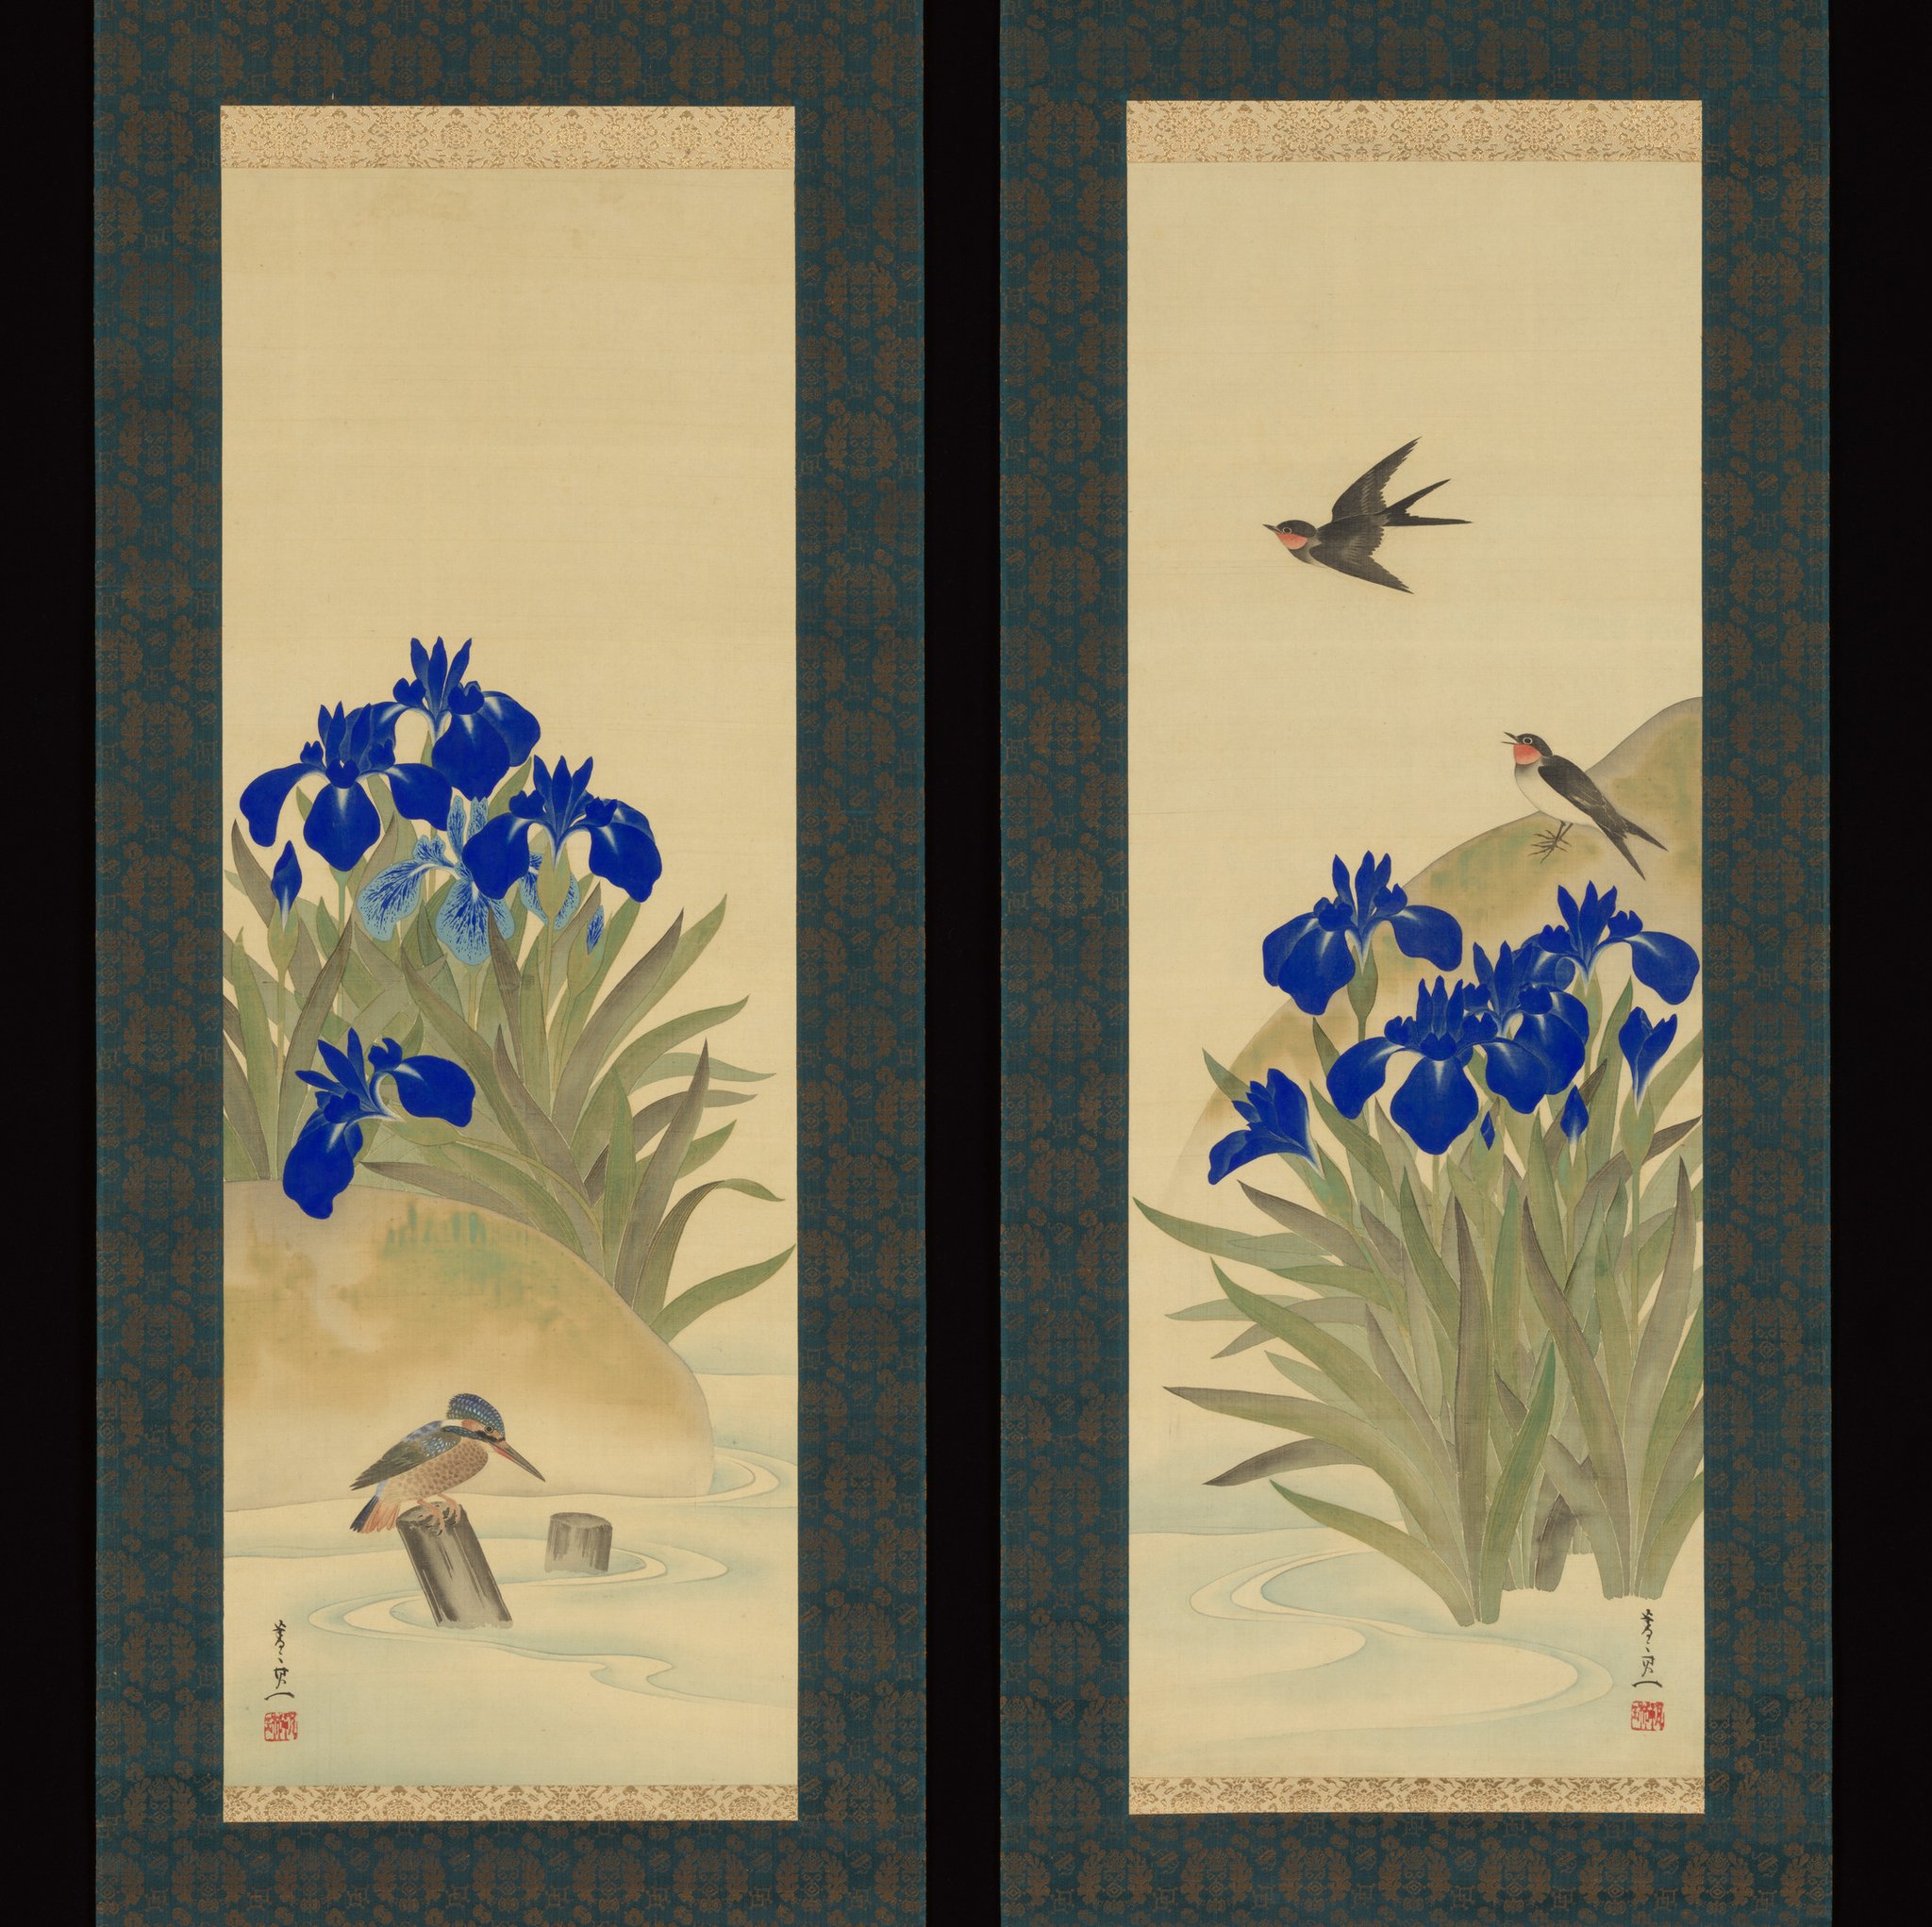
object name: hanging scroll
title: Irises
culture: japanese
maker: suzuki kiitsu 鈴木基一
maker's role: artist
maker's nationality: japanese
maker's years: 1796-1858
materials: ink, silk